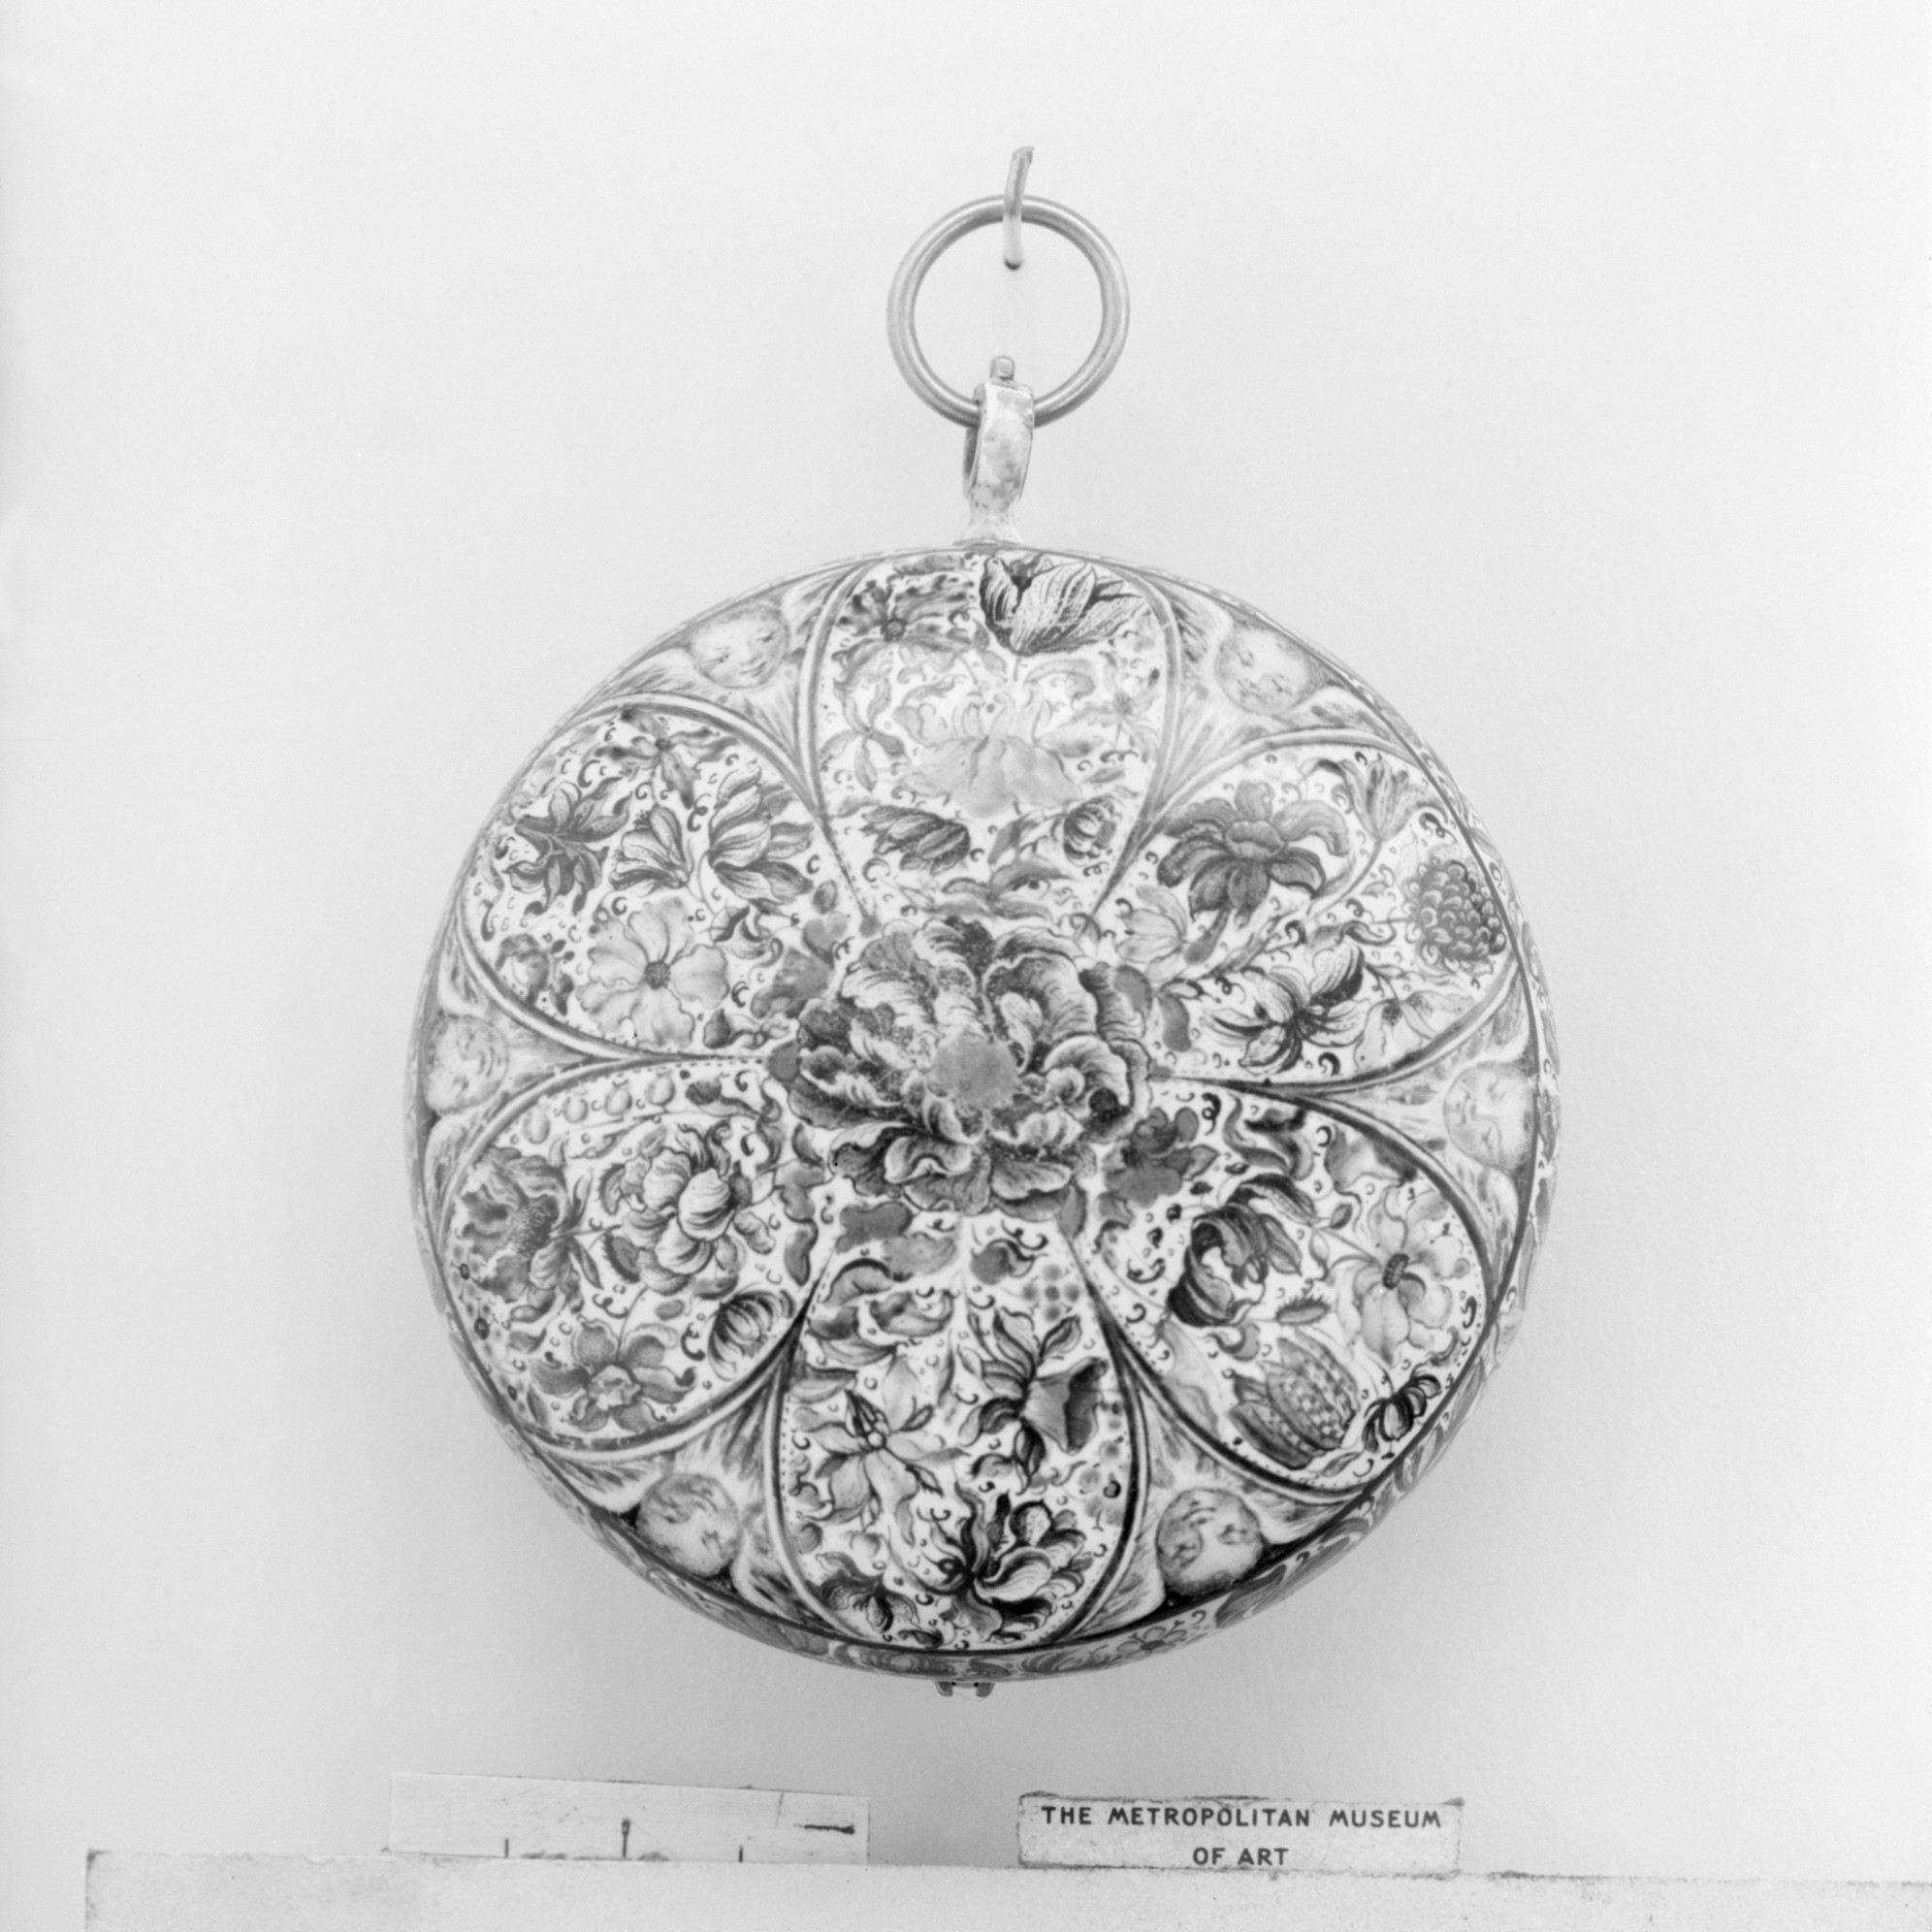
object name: watch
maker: etienne oltramare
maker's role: maker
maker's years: 1643-1693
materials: enamel, metal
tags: flowers